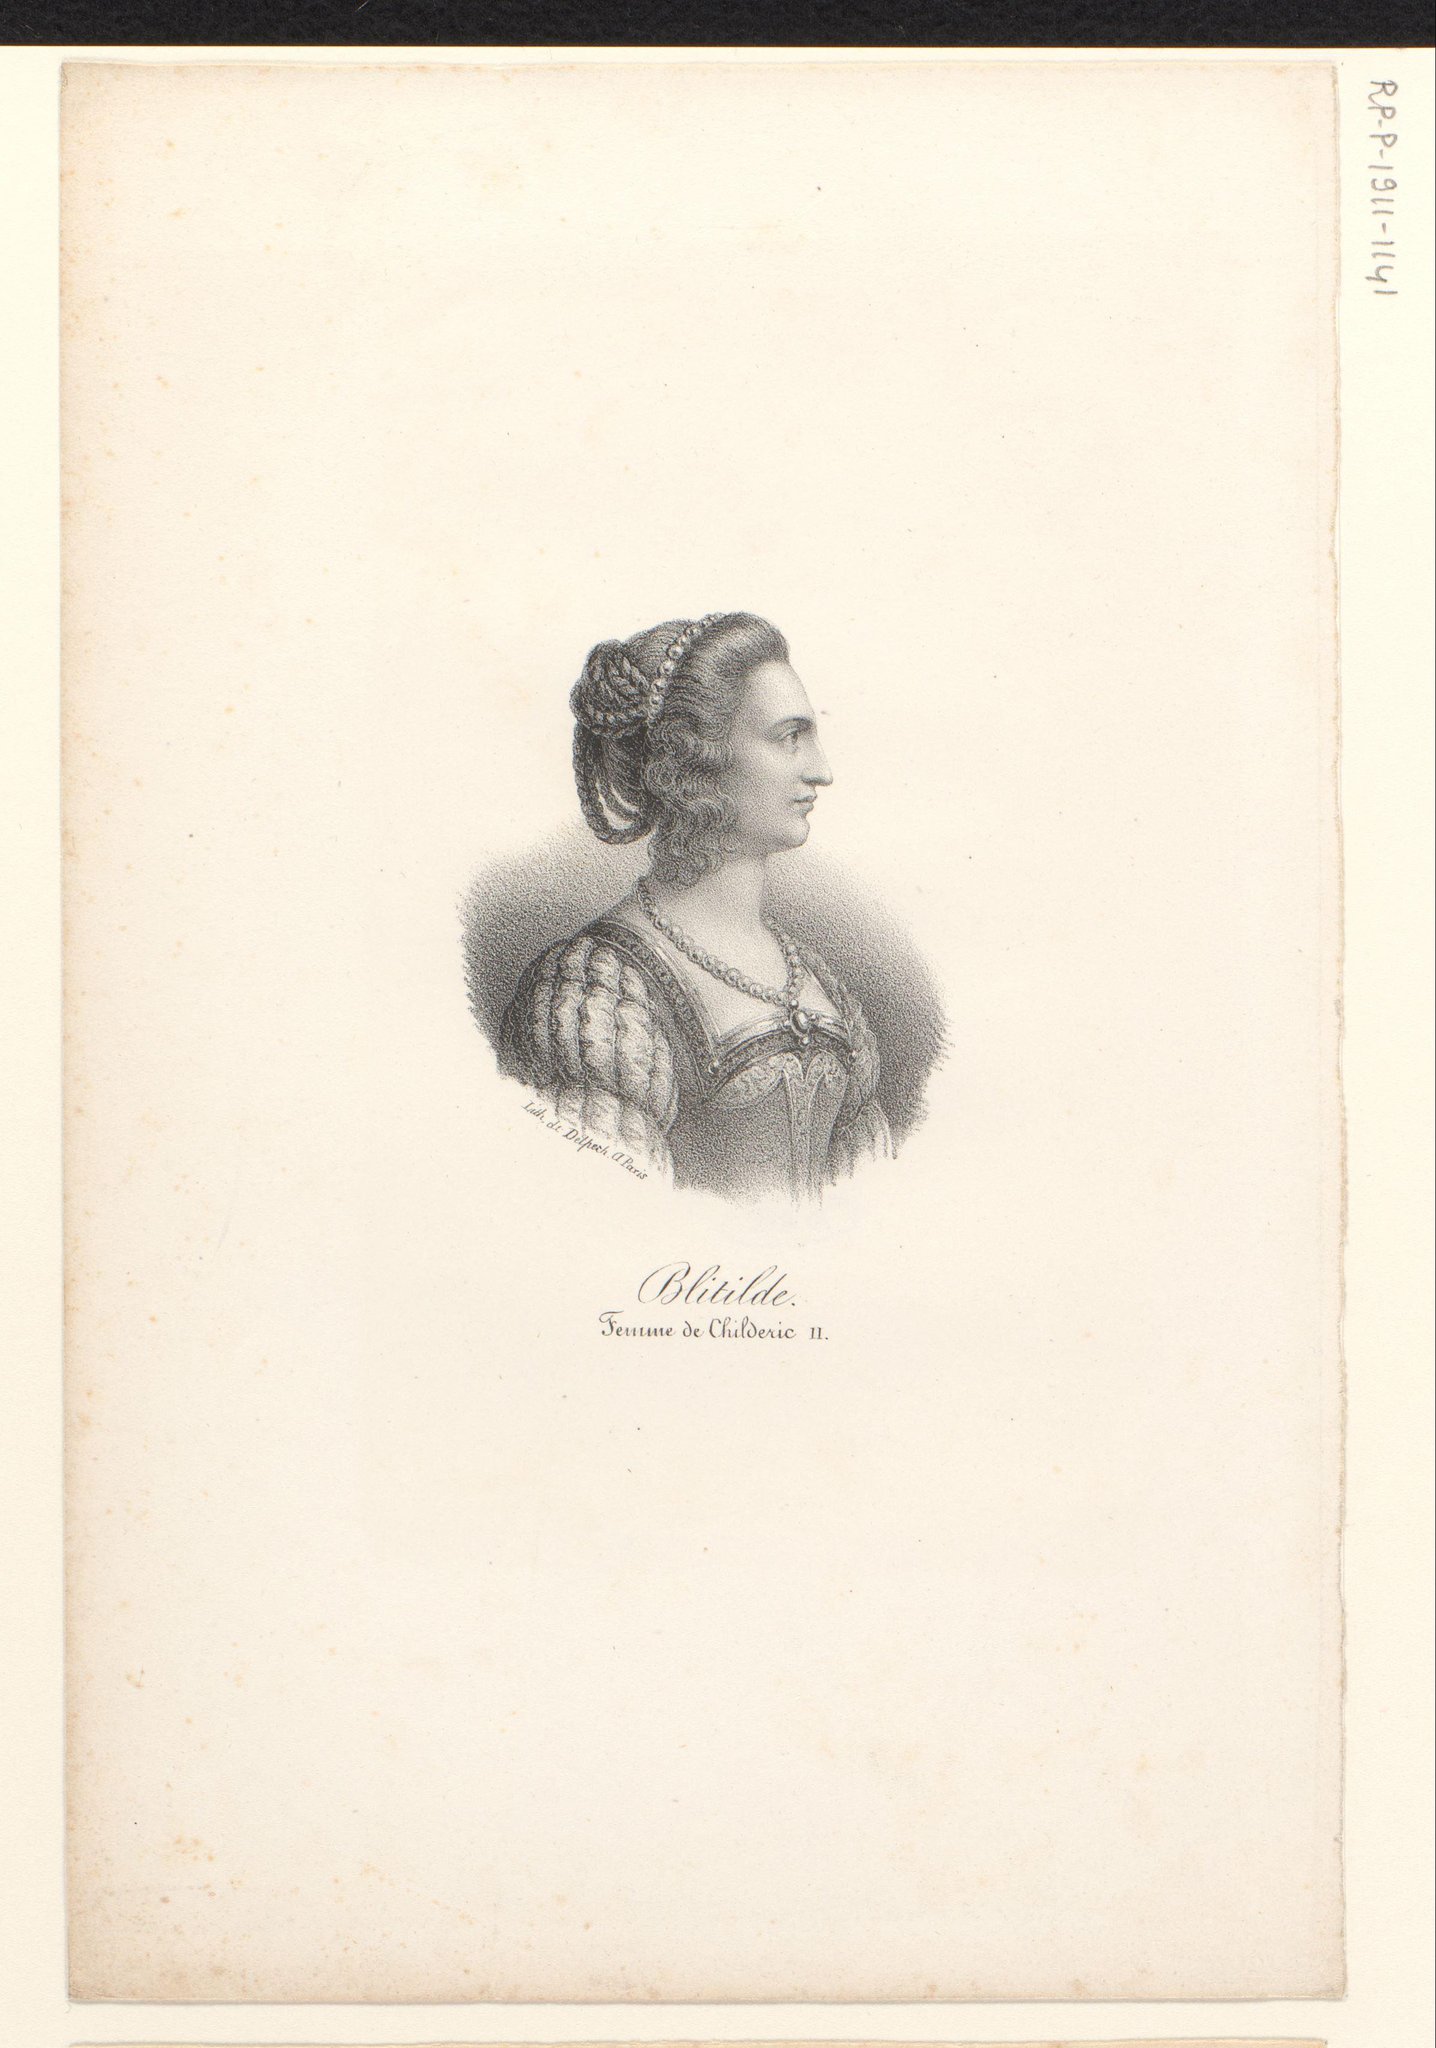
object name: print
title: Blitilde, femme de Childeric II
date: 1818-1842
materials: paper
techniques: lithograph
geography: paris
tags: historical persons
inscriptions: collector's mark: Lugt 2228a